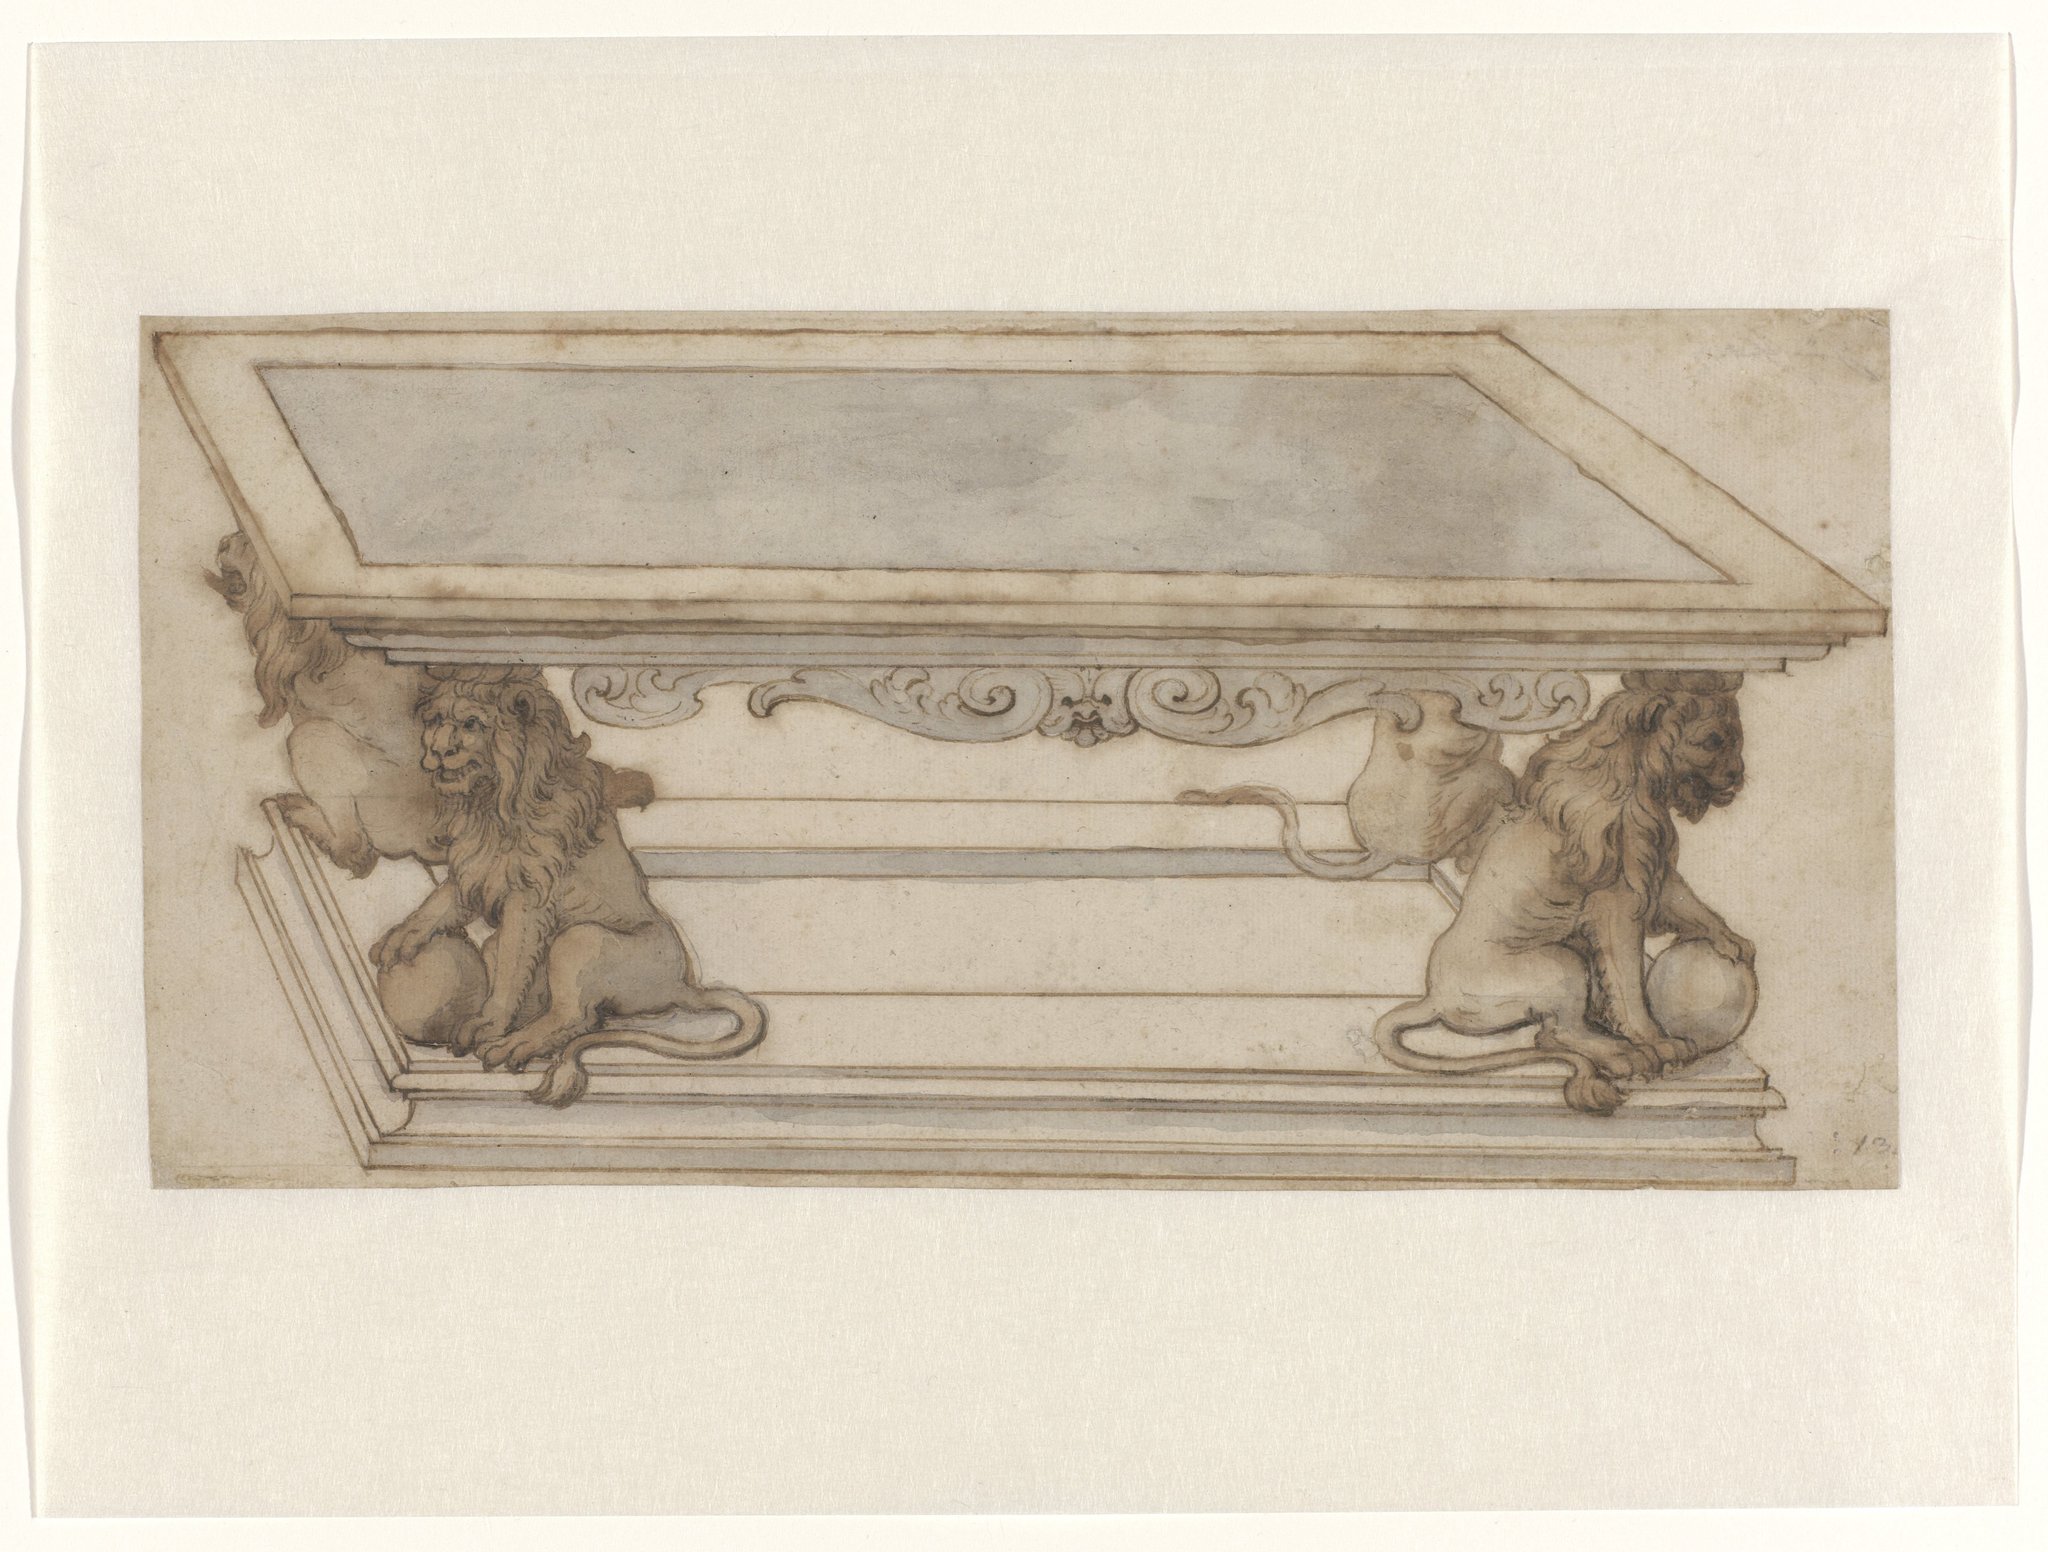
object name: drawing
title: Tekening van een tafel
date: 1650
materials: ink, paper, watercolor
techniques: brush, pen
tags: table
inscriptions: number: ‘13’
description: Aan de achterzijde is de tekening van de linker voorpoot van de tafel, in de vorm van een zittende leeuw met een bal, met rood krijt bedekt, terwijl de contouren van de leeuw zijn ingegrift. Zo kon de afbeelding aan de rechterzijde worden gedupliceerd; daar is de tekening van de rechter voorpoot op gebaseerd.